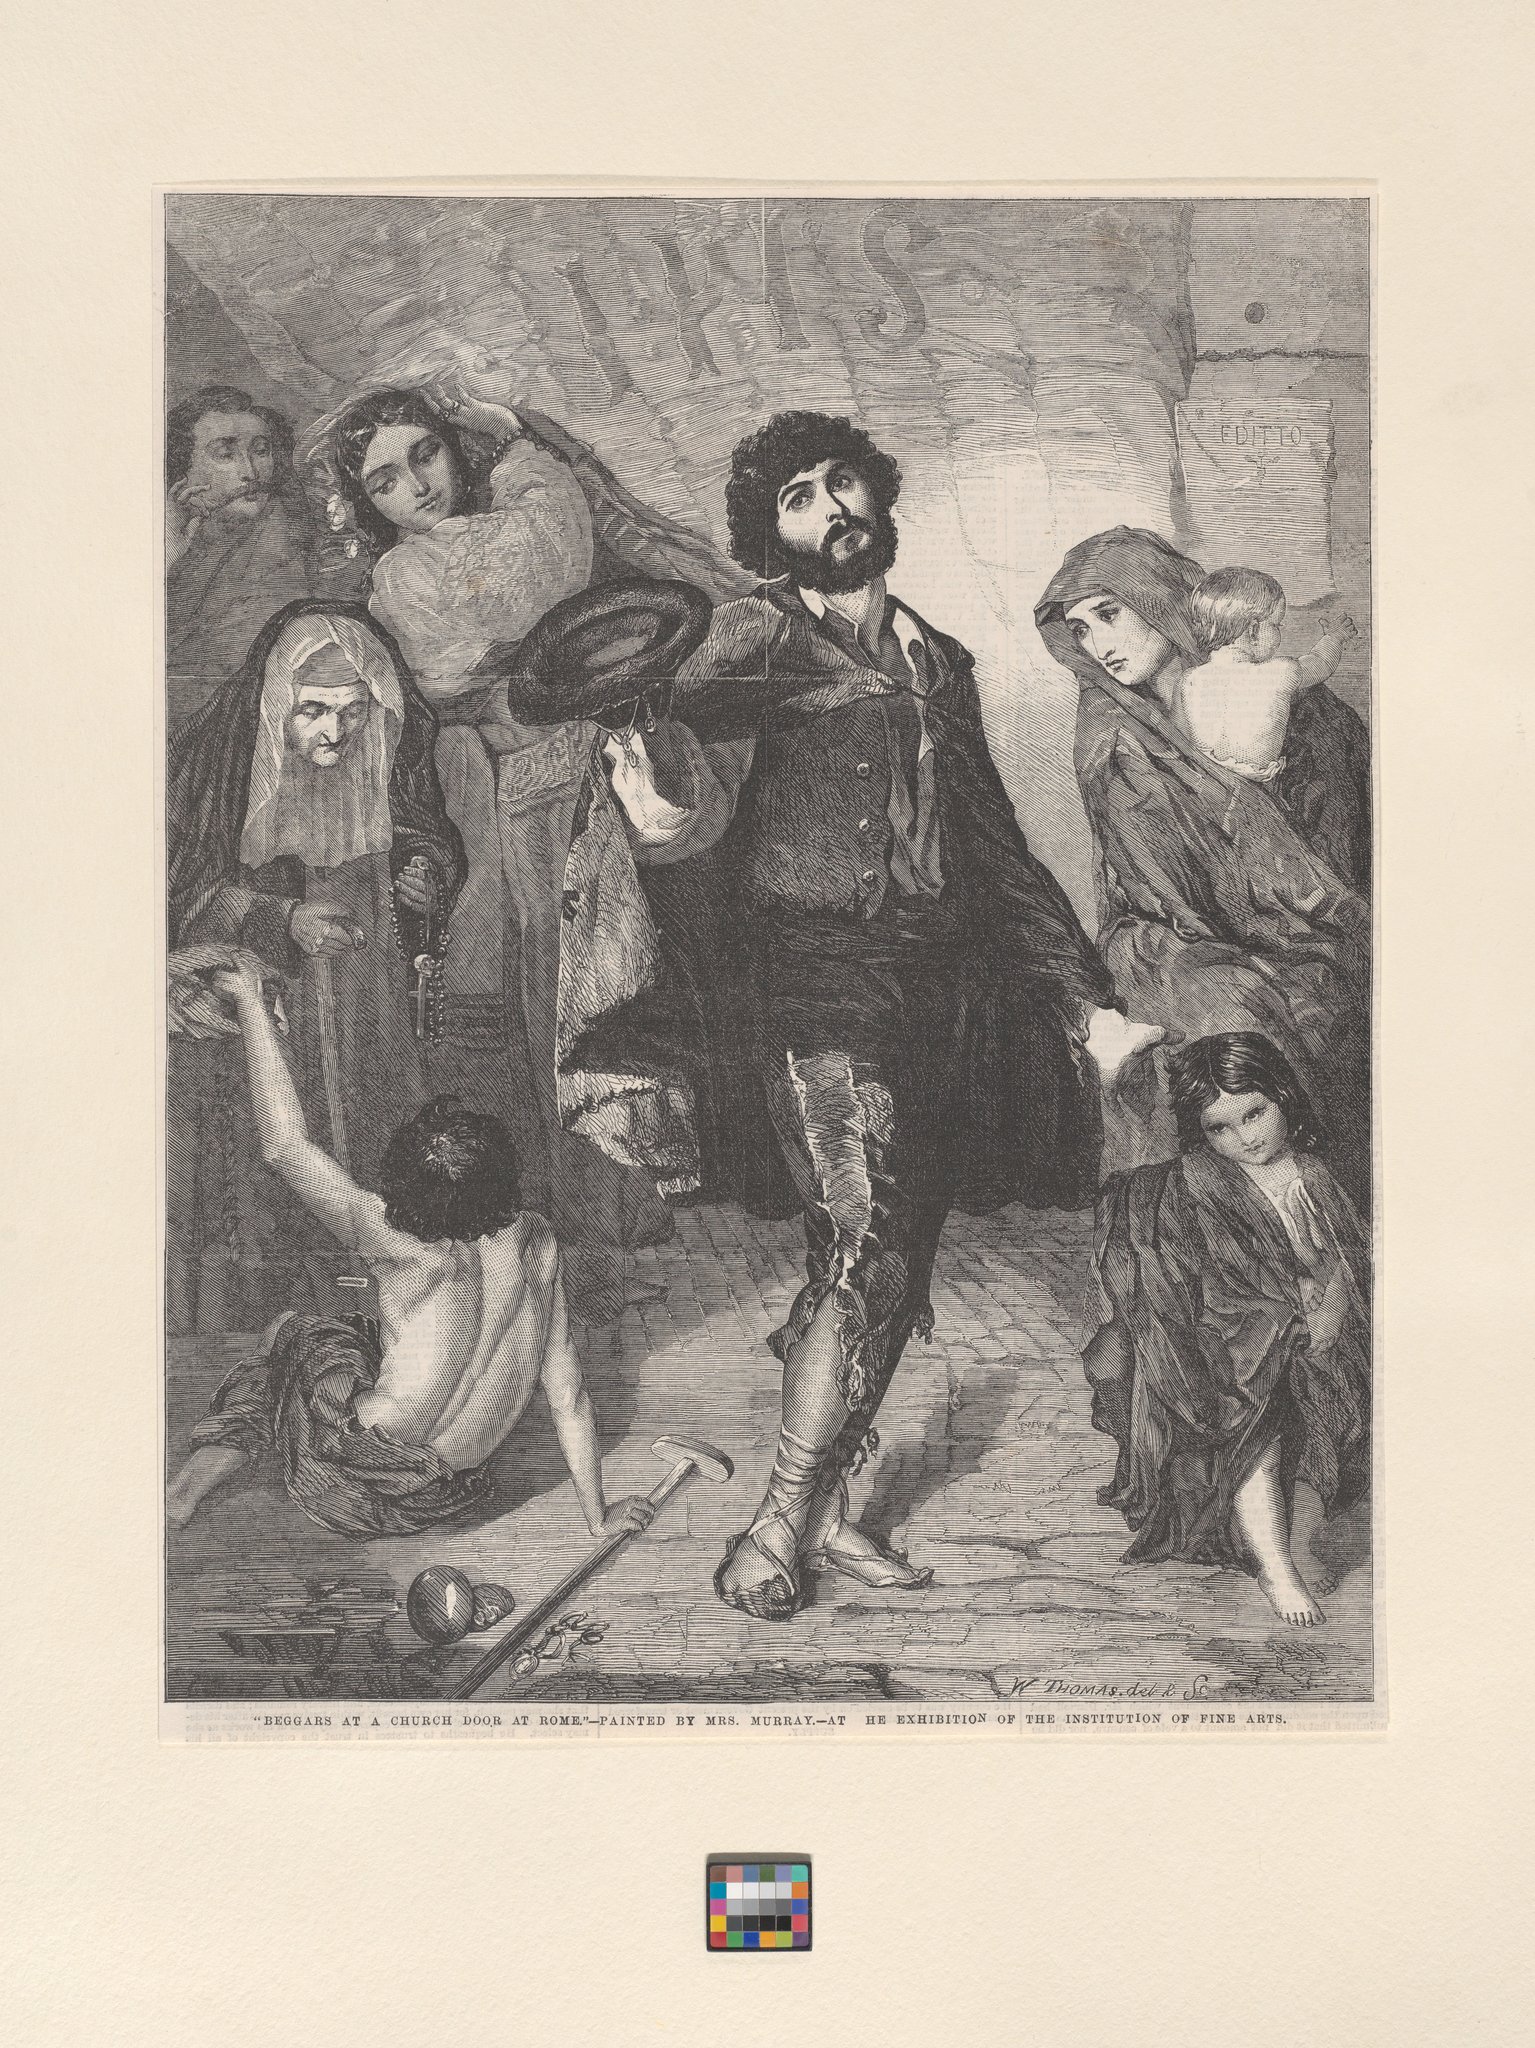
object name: print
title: Beggars at a Church Door at Rome, from "Illustrated London News"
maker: william luson thomas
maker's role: engraver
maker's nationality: british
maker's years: 1830-1900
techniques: engraving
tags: children,men,women